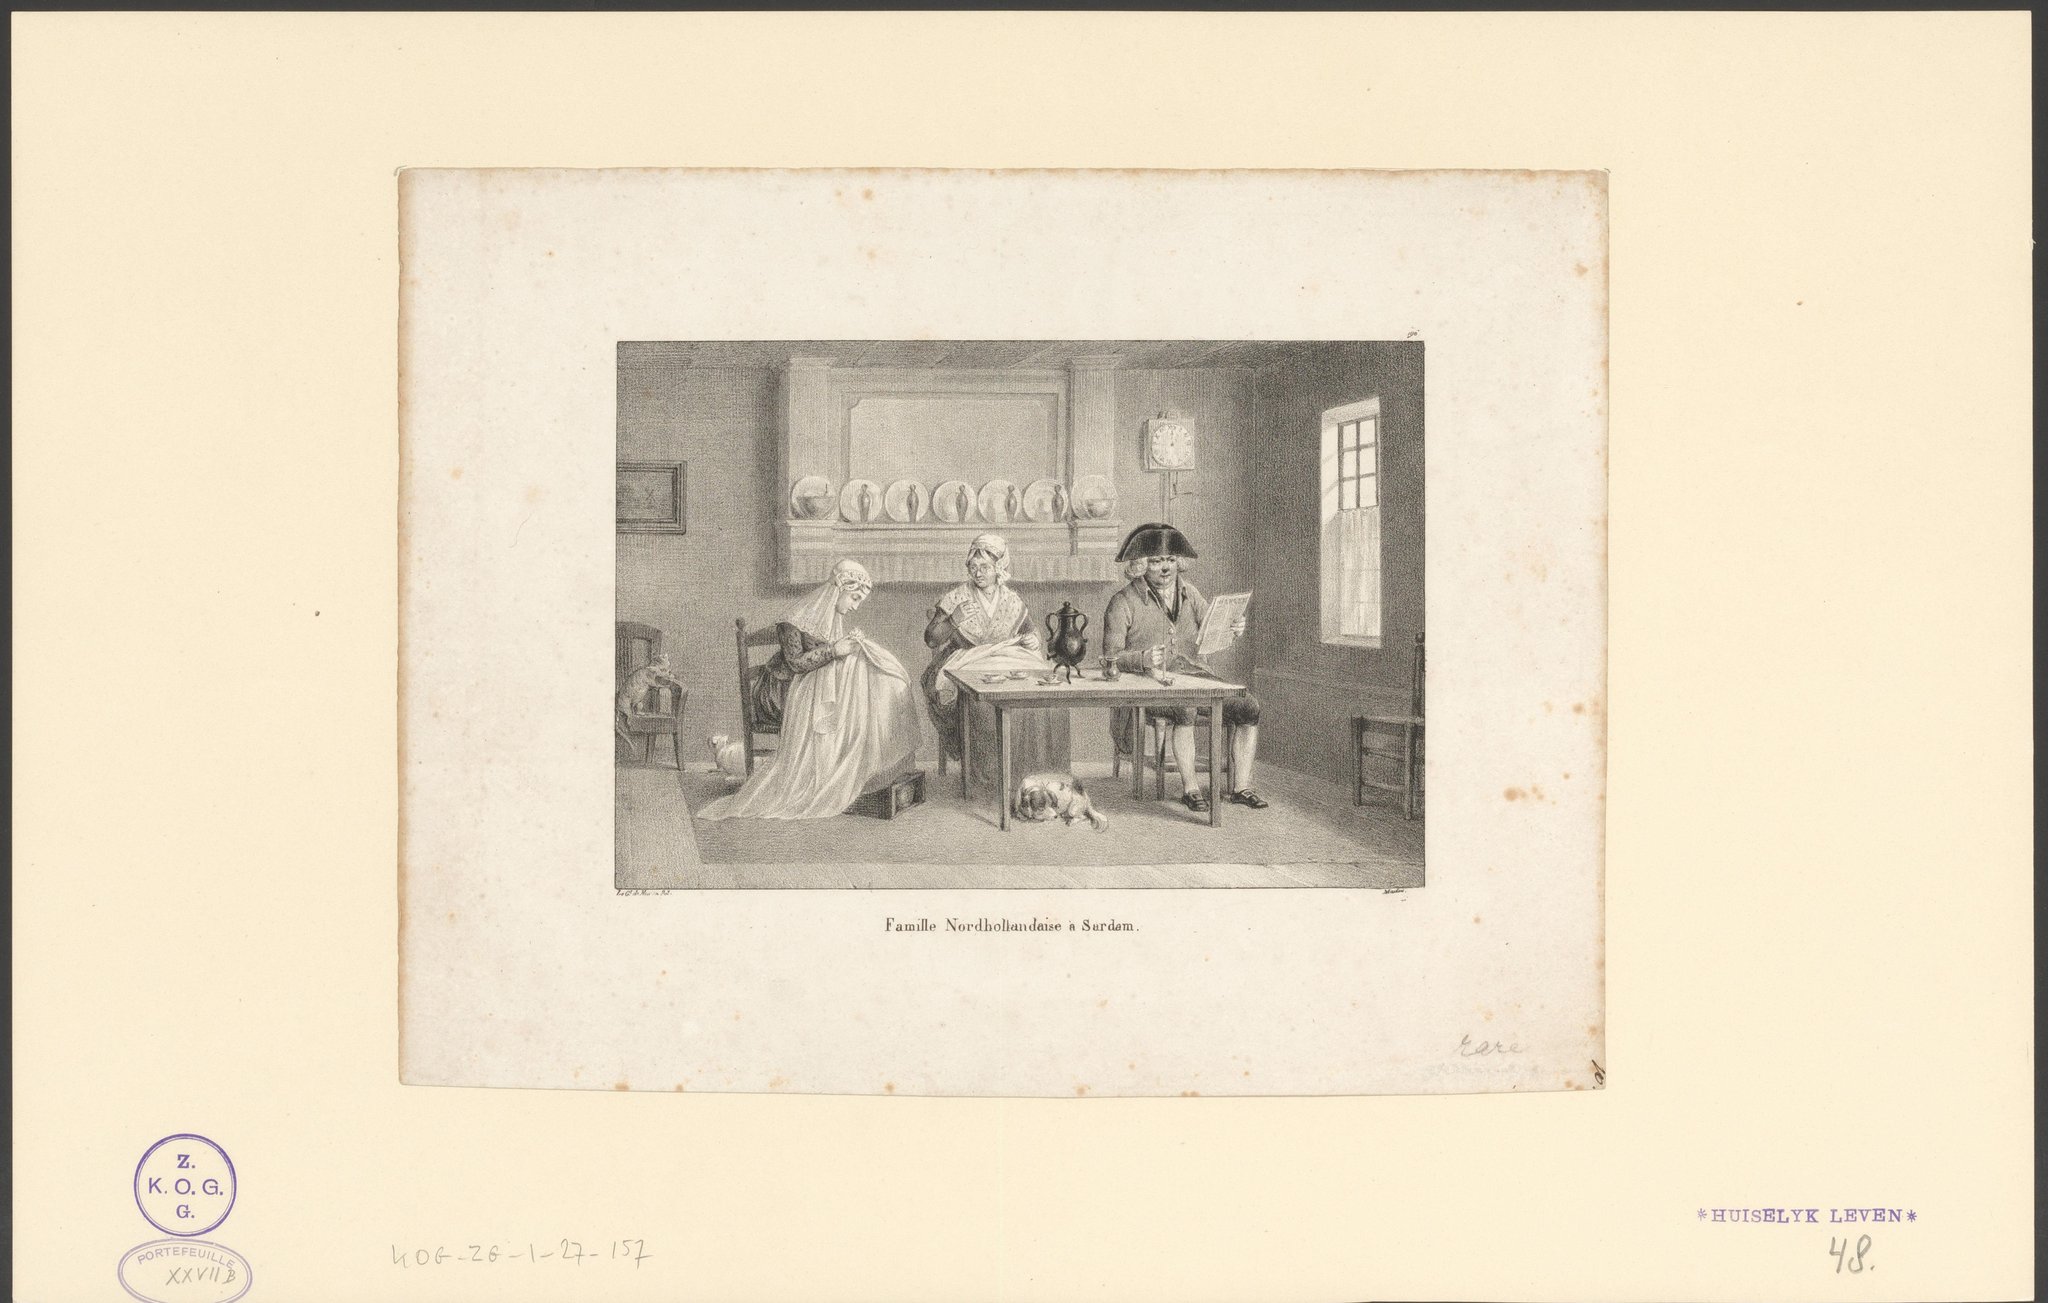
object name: book illustration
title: Man en twee vrouwen gezeten bij een tafel in een Zaandamse woonkamer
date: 1822-1825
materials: paper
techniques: lithograph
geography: brussels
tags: pipe ~ tobacco, family life at home, writing and letters, newspaper, news-sheet, living-room, parlour, sitting-room, sewing, dog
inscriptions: collector's mark: Lugt 1641, collector's mark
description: Prent verschenen in: De Cloet, Jean. Voyage pittoresque dans le royaume des Pays Bas. Brussel: Jean Baptiste Ambroise Marcellin Jobard, 1825. Afleveringen voor deze publicatie verschijnen vanaf 1822. In 1825 zijn er onder deze titel twee banden vervaardigd. Wegens succes kreeg de publicatie een vervolg onder de titel 'Châteaux et monumens des Pays-Bas faisant suite au voyage pittoresque'.